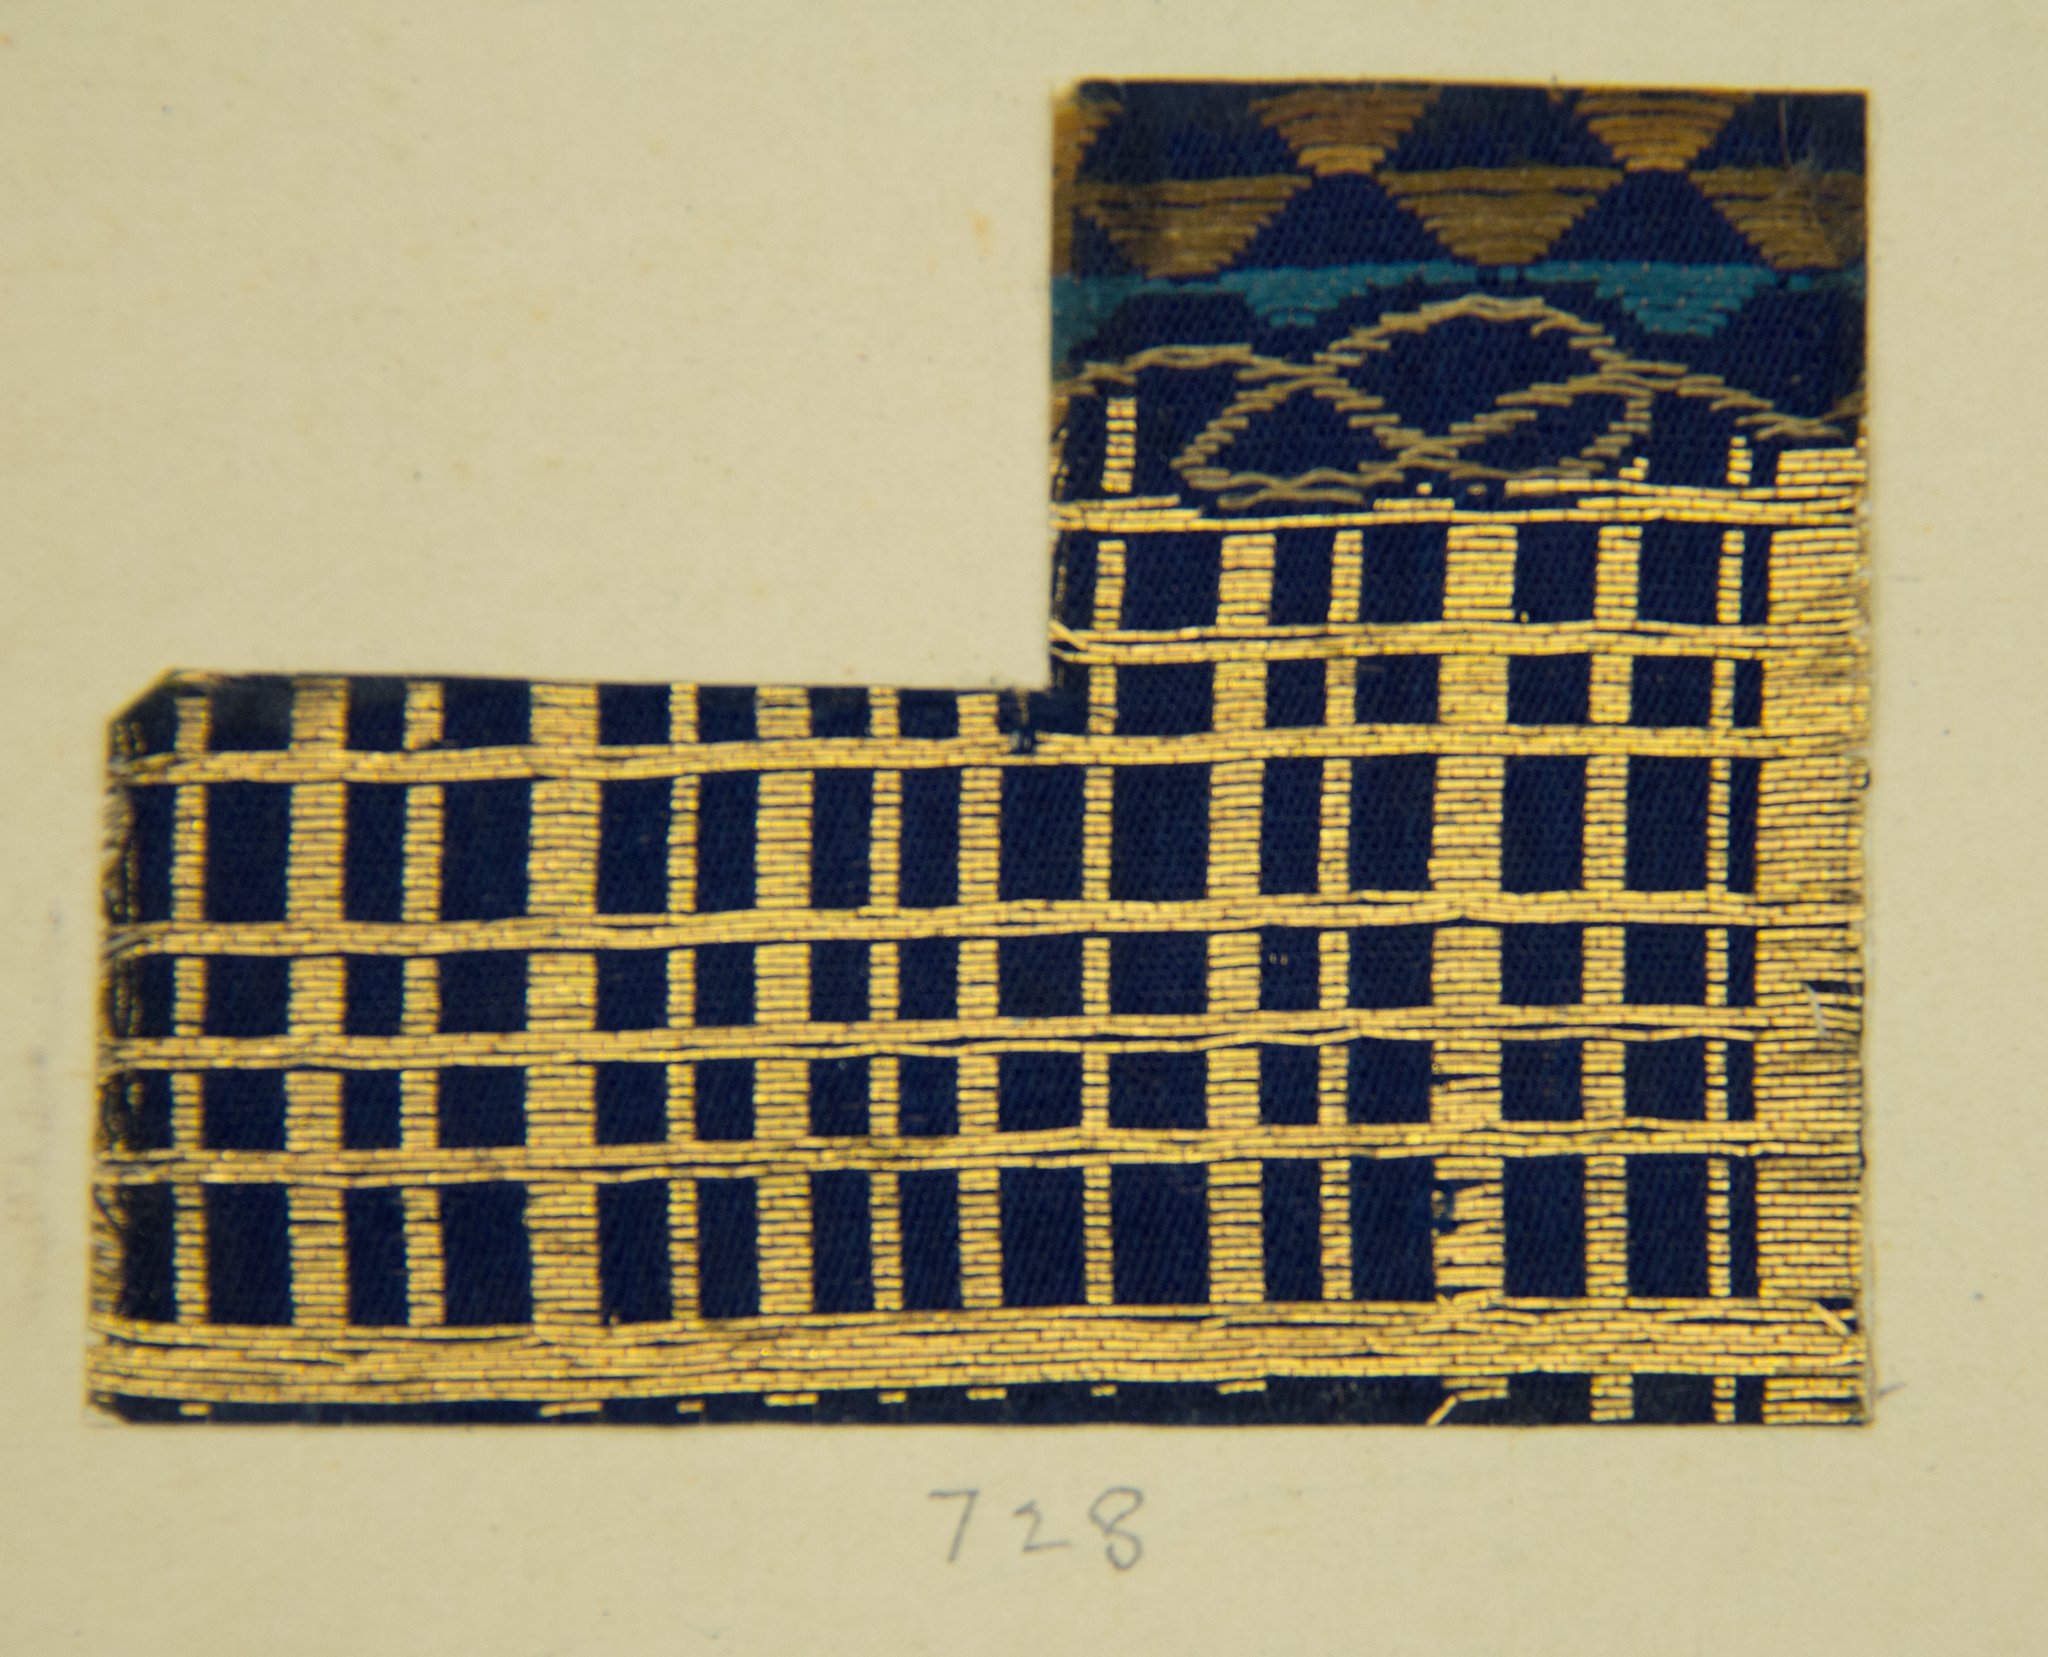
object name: piece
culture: japanese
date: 1601-1700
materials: silk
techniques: compound weave